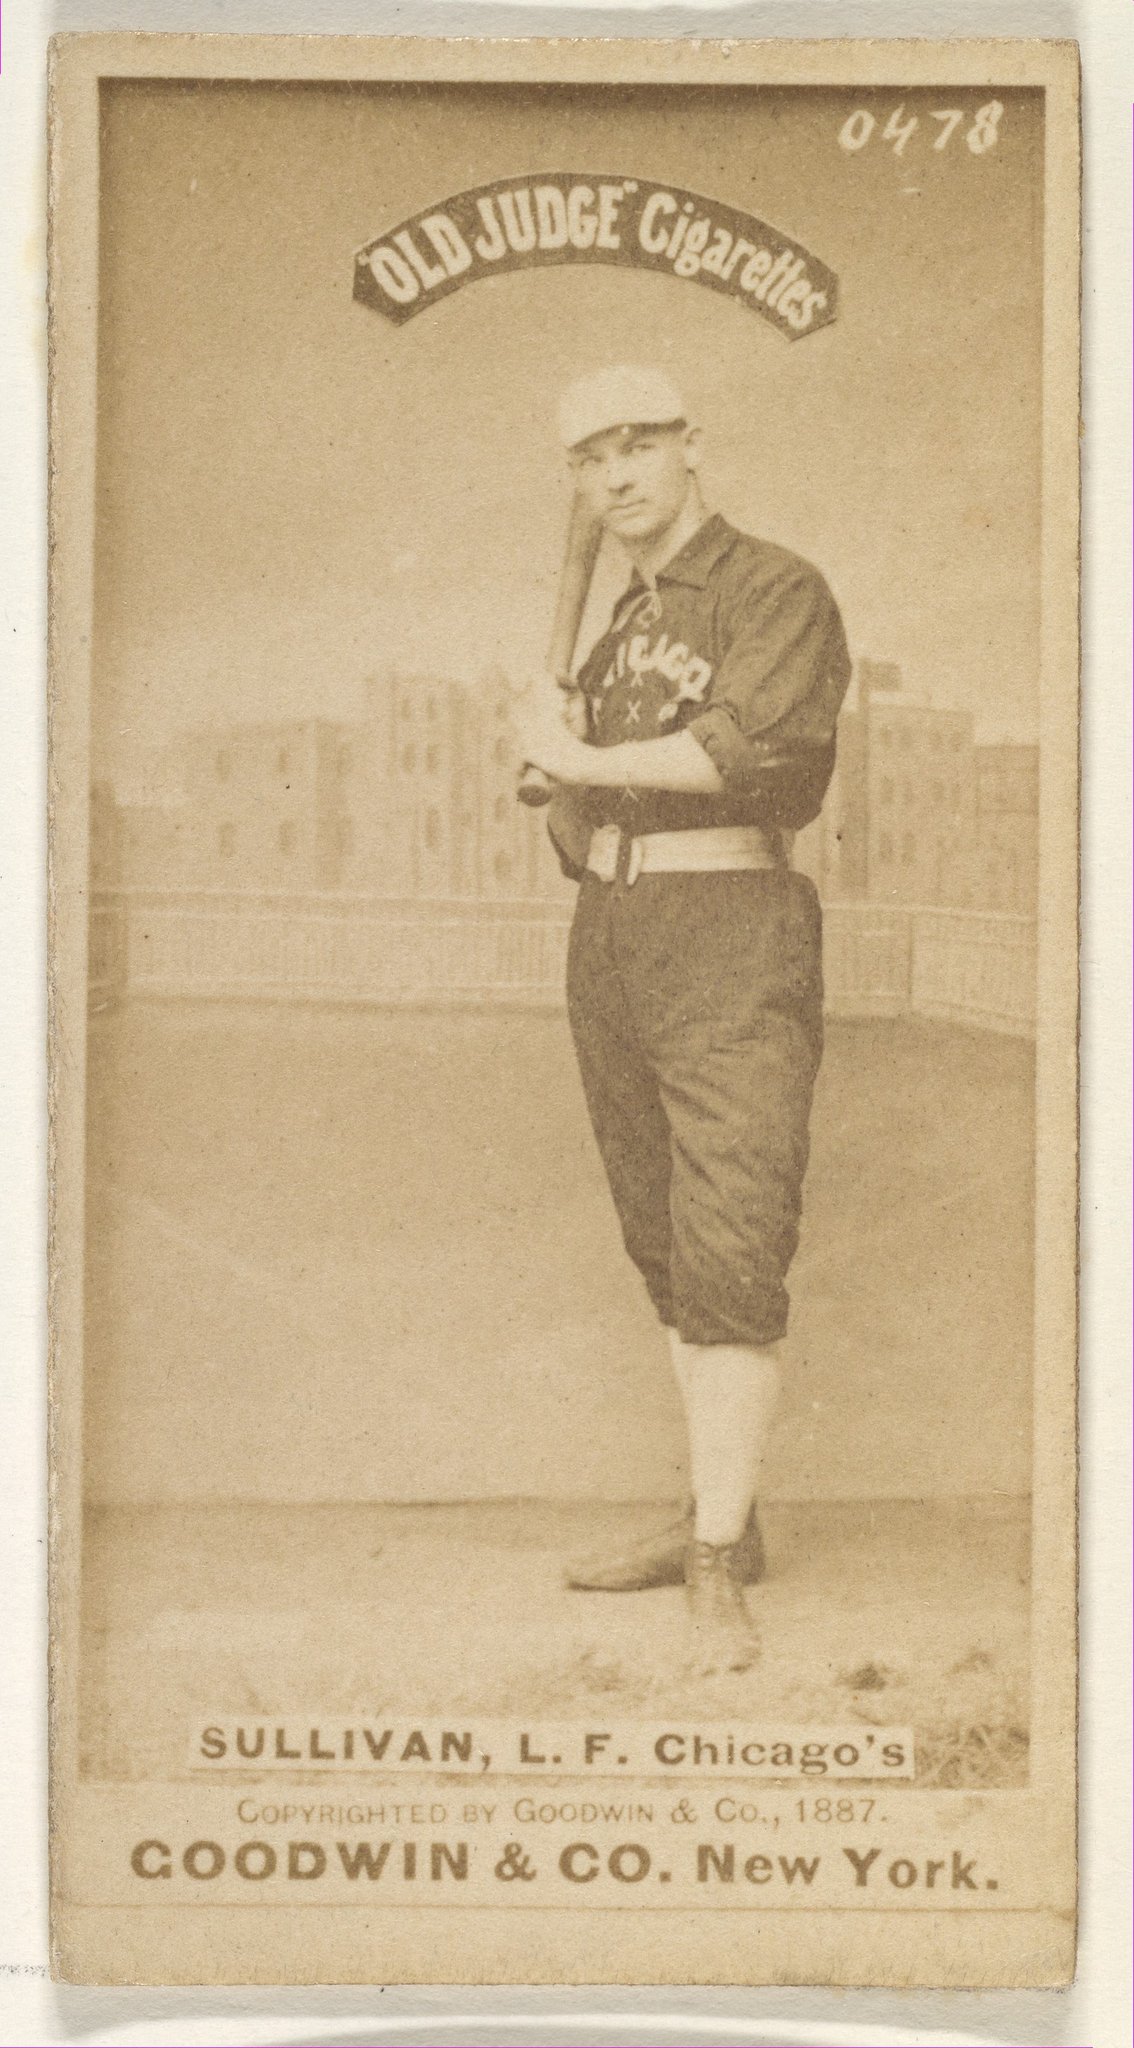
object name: baseball card, photograph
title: Sullivan, Left Field, Chicago, from the Old Judge series (N172) for Old Judge Cigarettes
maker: goodwin & company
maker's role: publisher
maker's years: 1850-1950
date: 1887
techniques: albumen silver print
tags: men,portraits,baseball,athletes